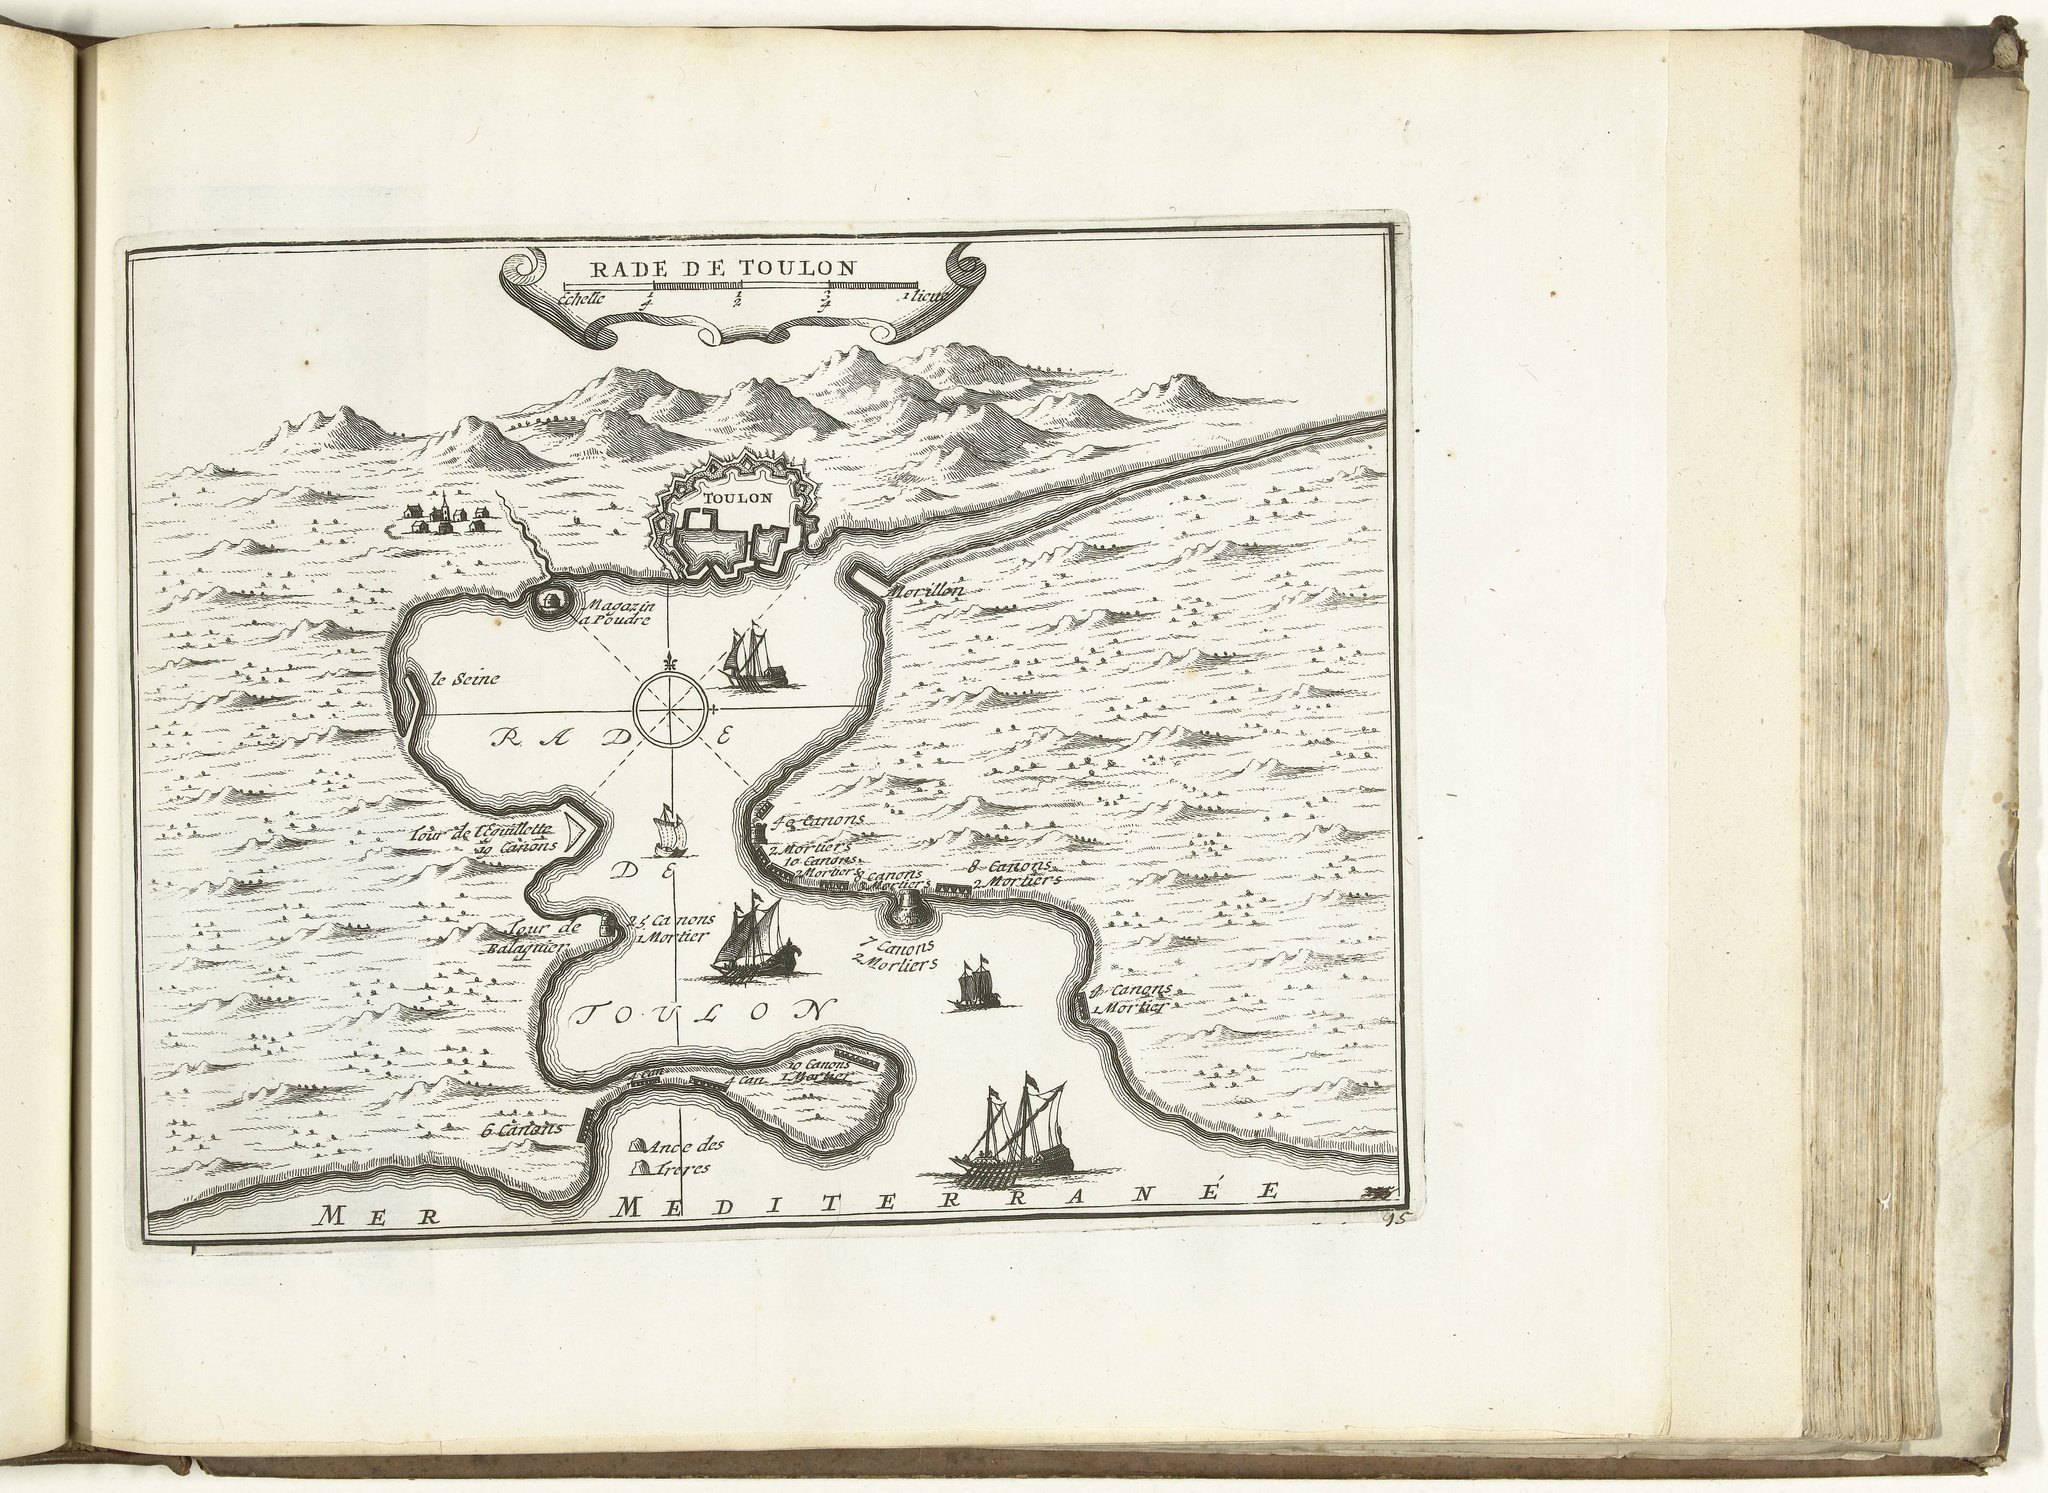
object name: map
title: Rede van Toulon, 1726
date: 1726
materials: paper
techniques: etching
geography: northern netherlands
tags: maps of separate countries or regions, toulon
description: Kaart van de rede van de Franse havenstad Toulon. Plaat nr. 95 in deel IV van het prentwerk: Les Forces de l'Europe, Asie, Afrique et Amerique ... Comme aussi les Cartes des Côtes de France et d'Espagne uit 1726, dit eerste deel met 238 met de hand genummerde platen van vermaarde sterke steden en vestingen in het kader van de Spaanse Successieoorlog 1701-1713. Voor het merendeel zijn deze platen gekopieerd naar de anonieme Franse platen van vermaarde sterke steden en vestingen: in Les forces de l'Europe en in: Le theatre de la guerre, dans les Pays-Bas, beide oorspronkelijk uitgegeven door Nicolas de Fer te Parijs (1693-1697) in het kader van de Negenjarige Oorlog. Titel en opschriften in het Frans. Rechtsonder het nummer 255 met de pen doorgekrast.